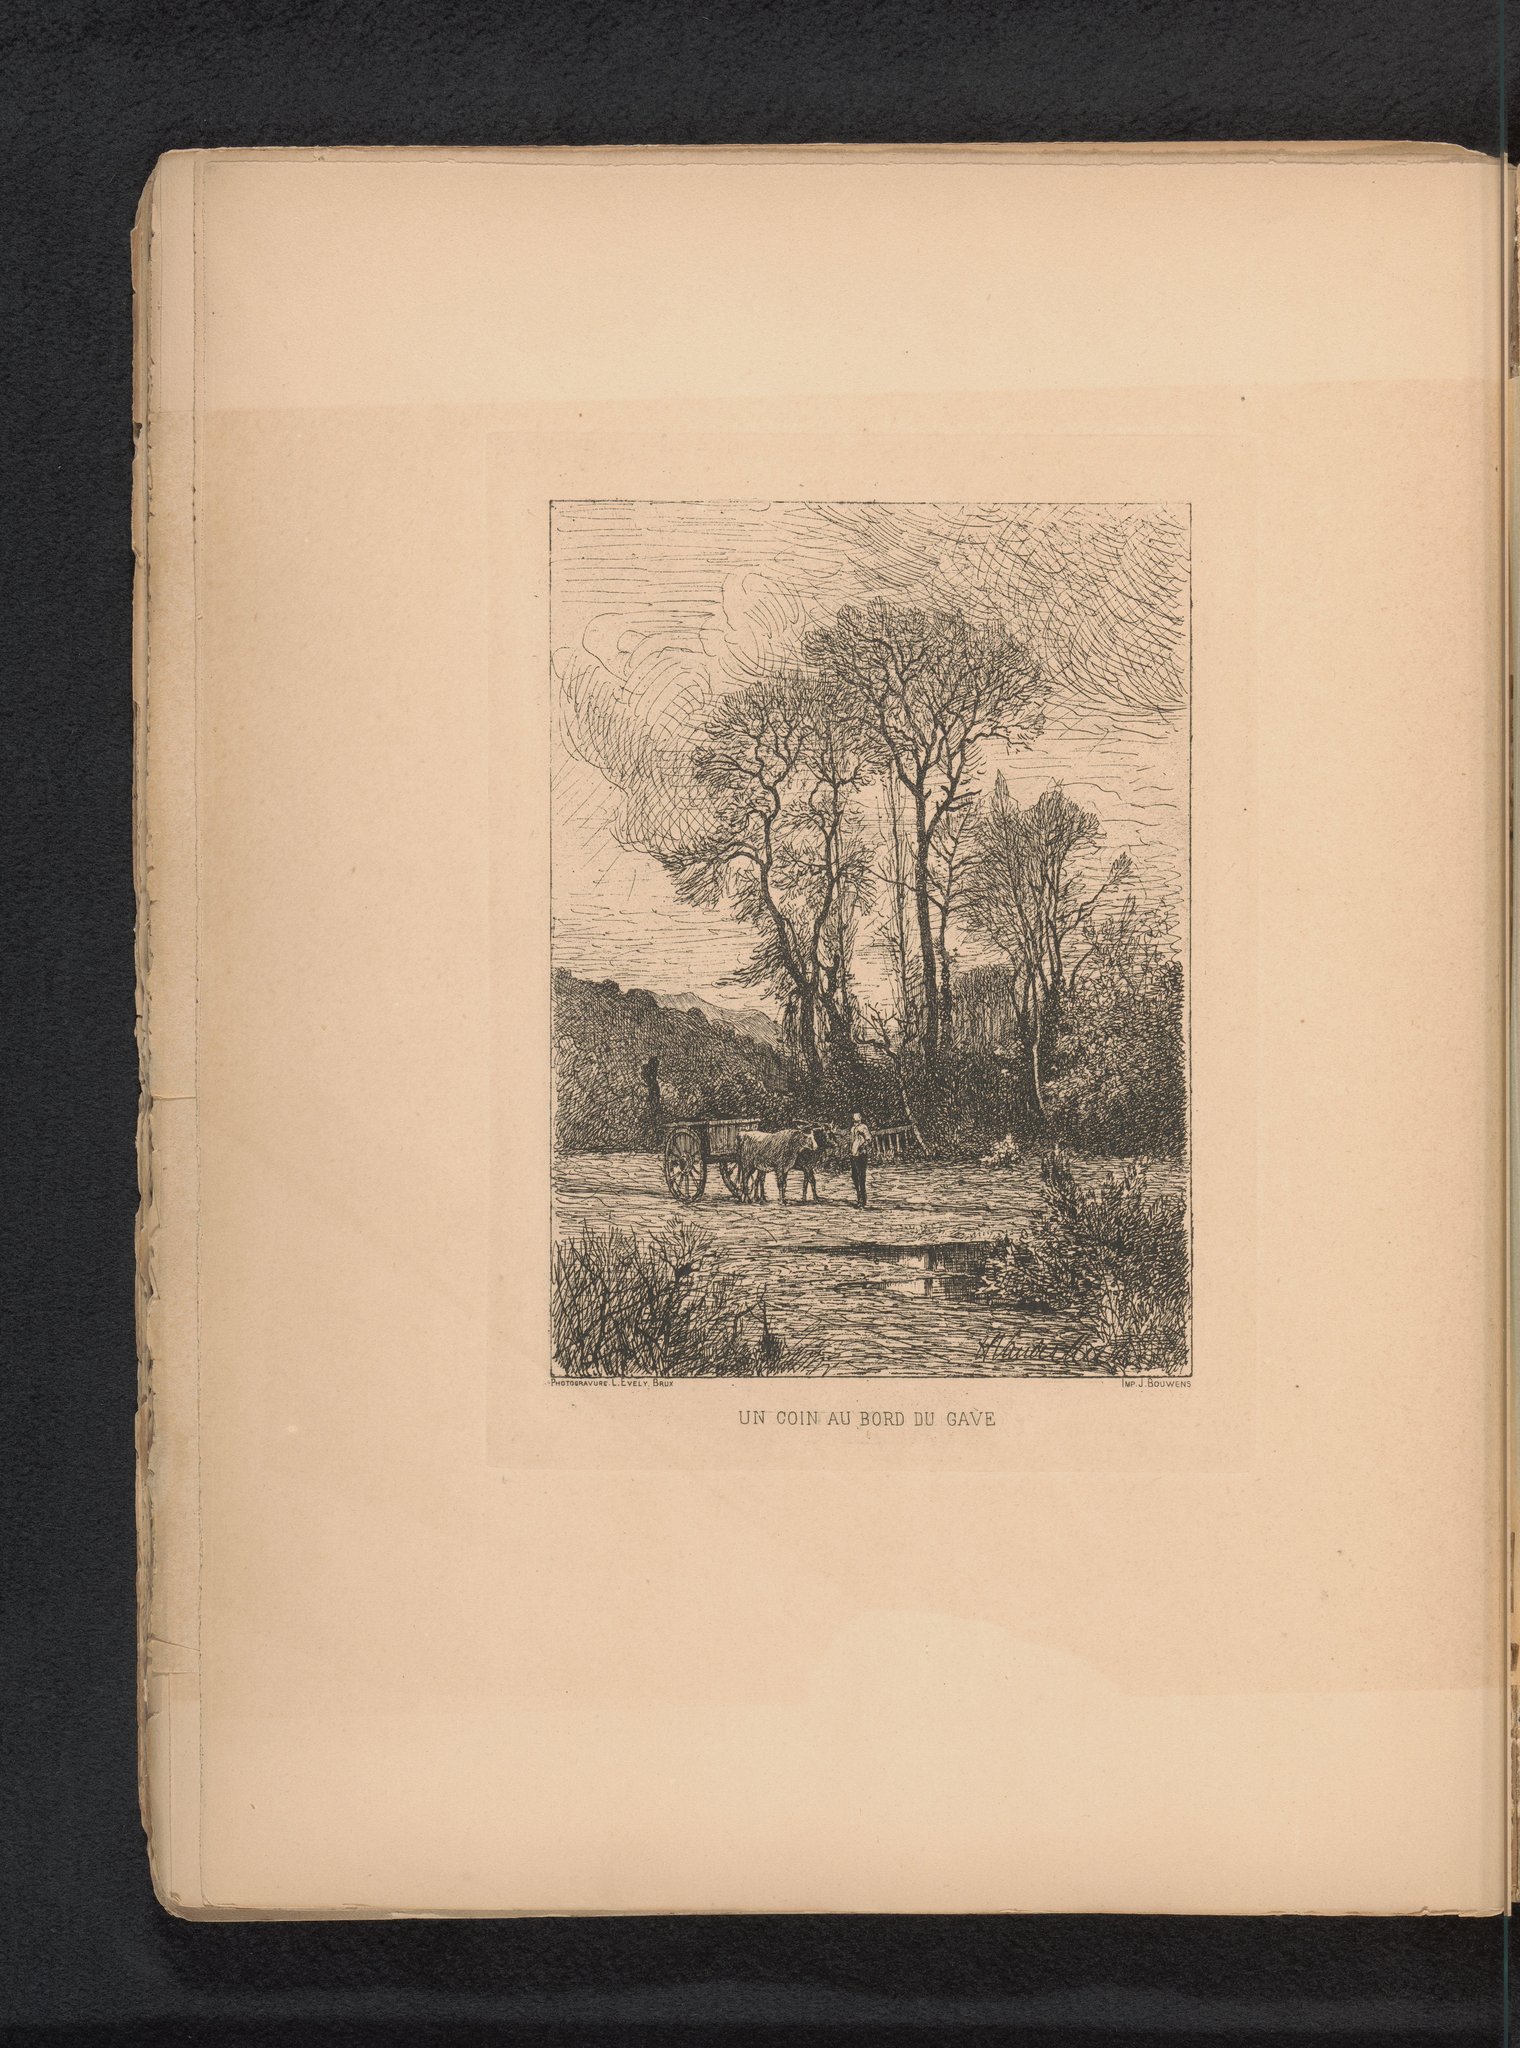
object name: page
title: Reproductie van een tekening van een man met twee koeien voor een wagen in een landschap door Hendrick van der Hecht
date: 1878-1883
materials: paper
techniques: photoaquatint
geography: brussels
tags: landscapes, two-wheeled vehicle drawn by two animals (+ one person ~ traffic and transport)